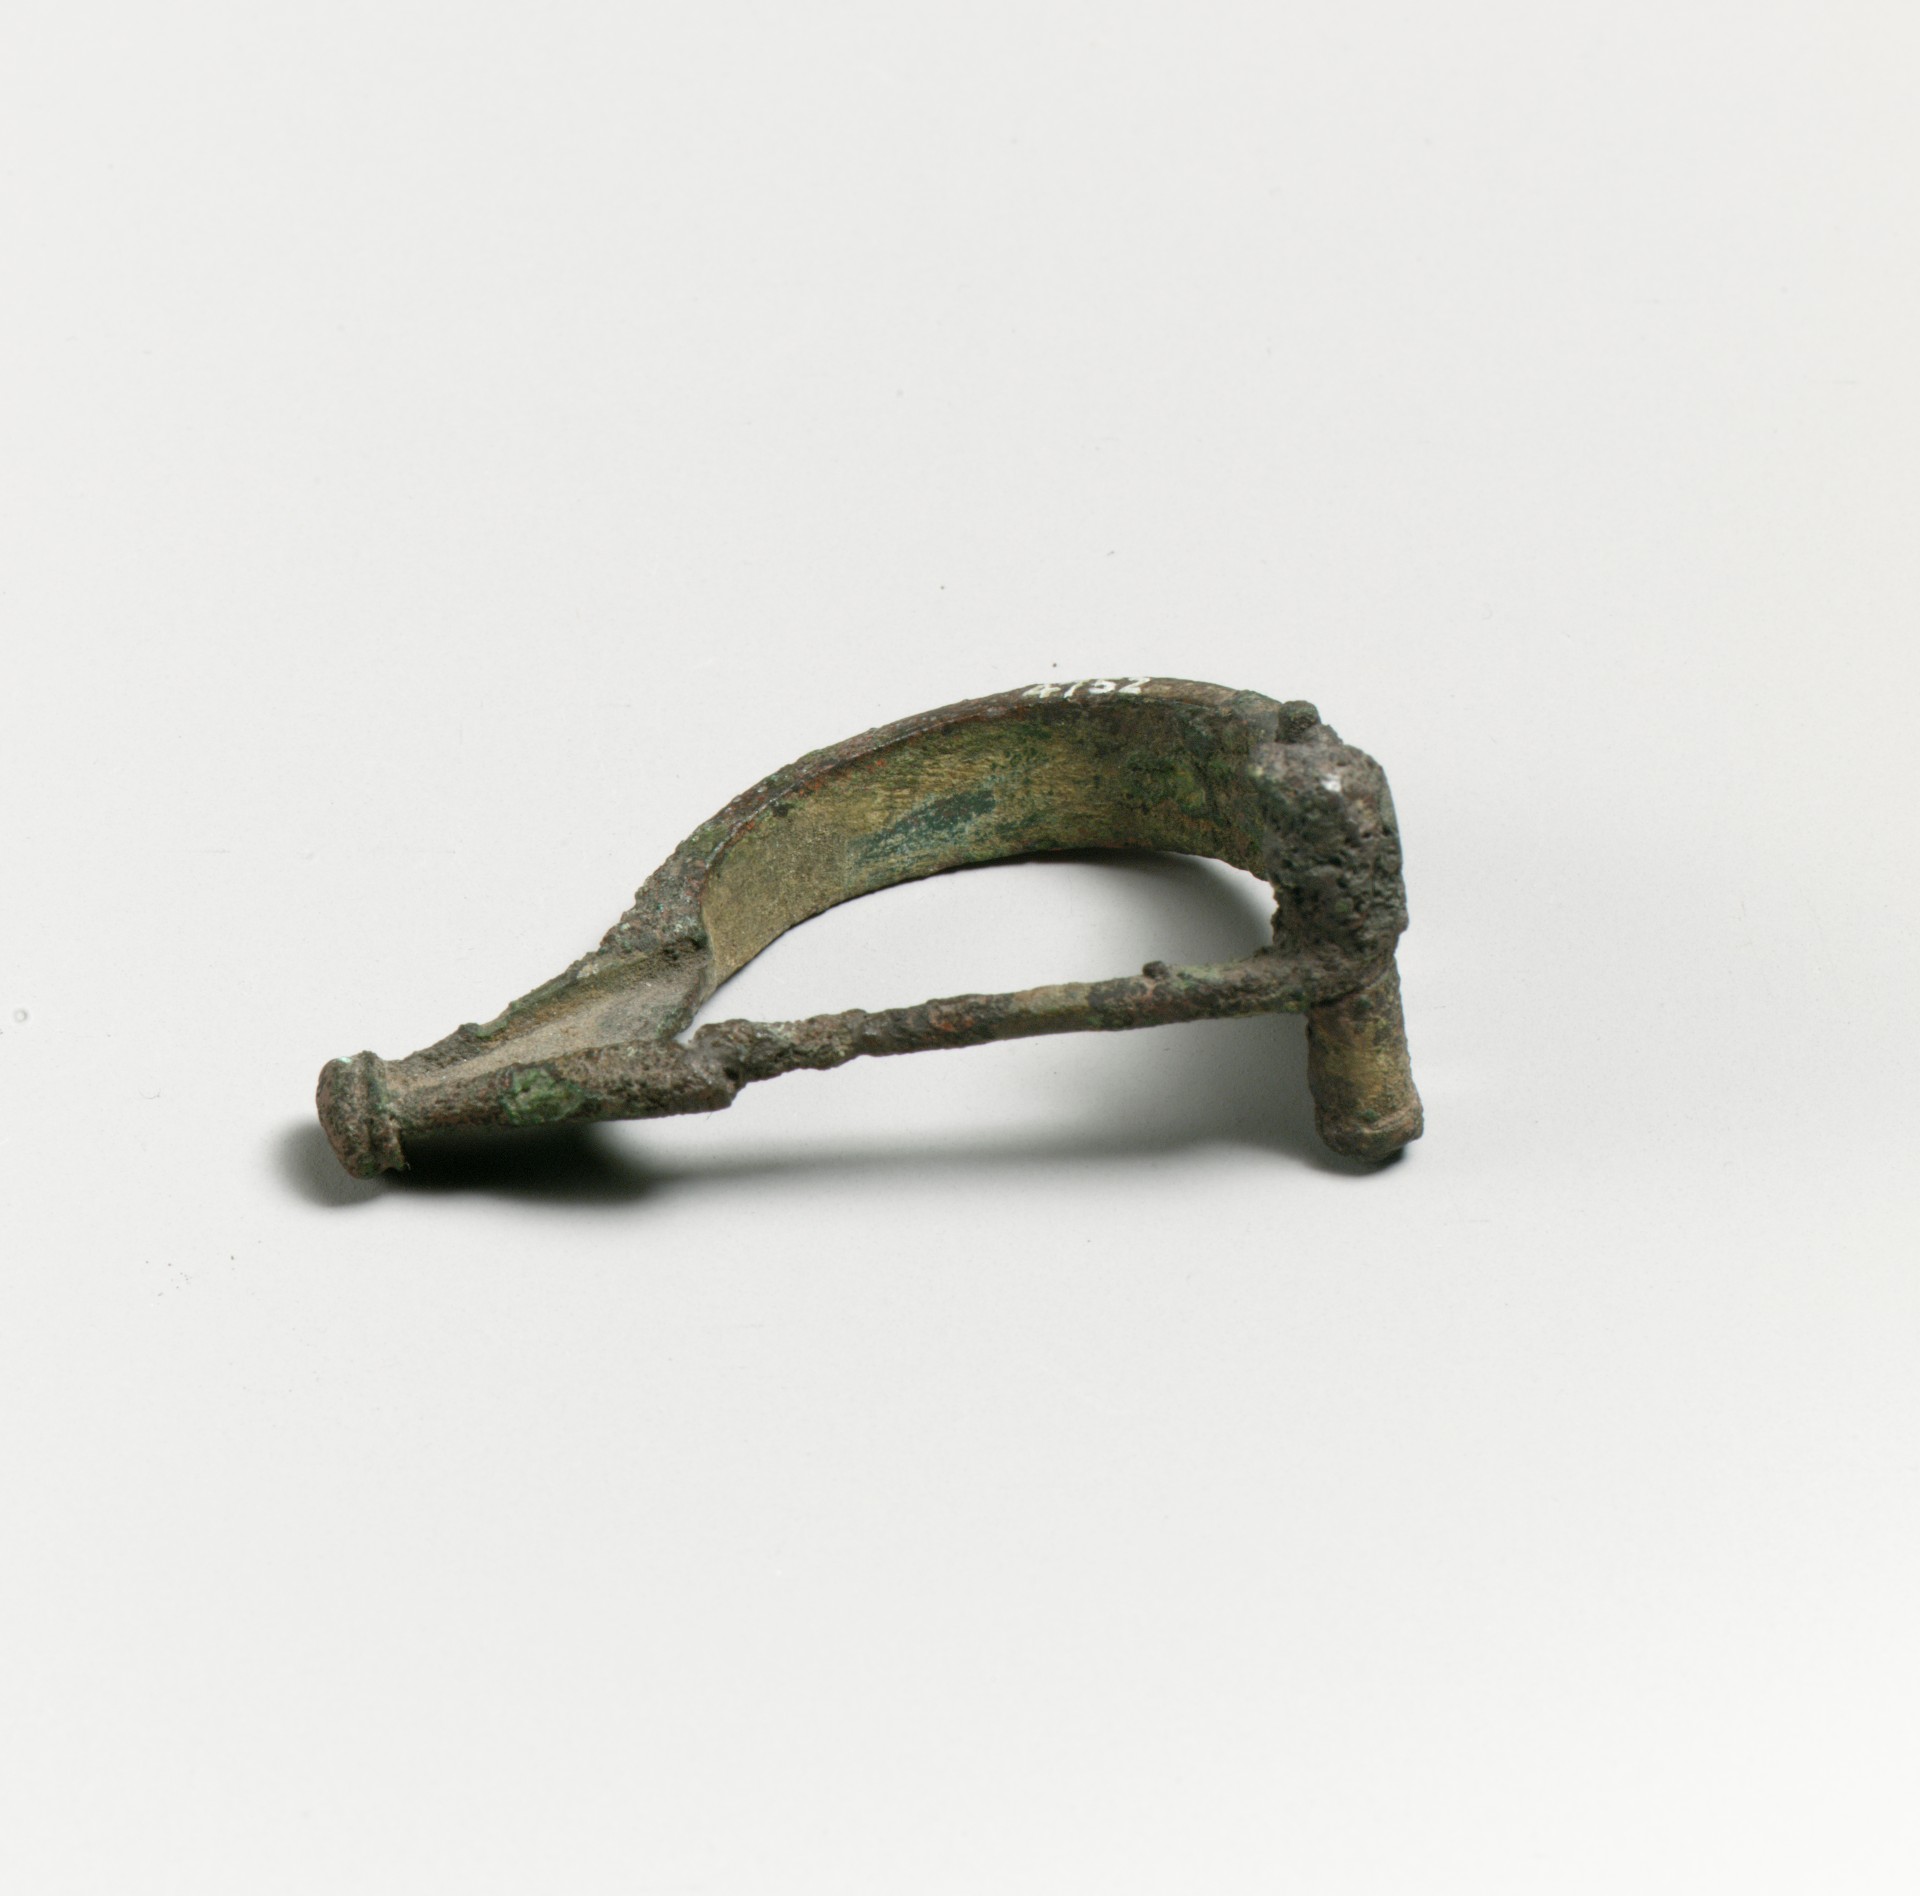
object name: fibula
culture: roman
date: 67-100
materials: bronze